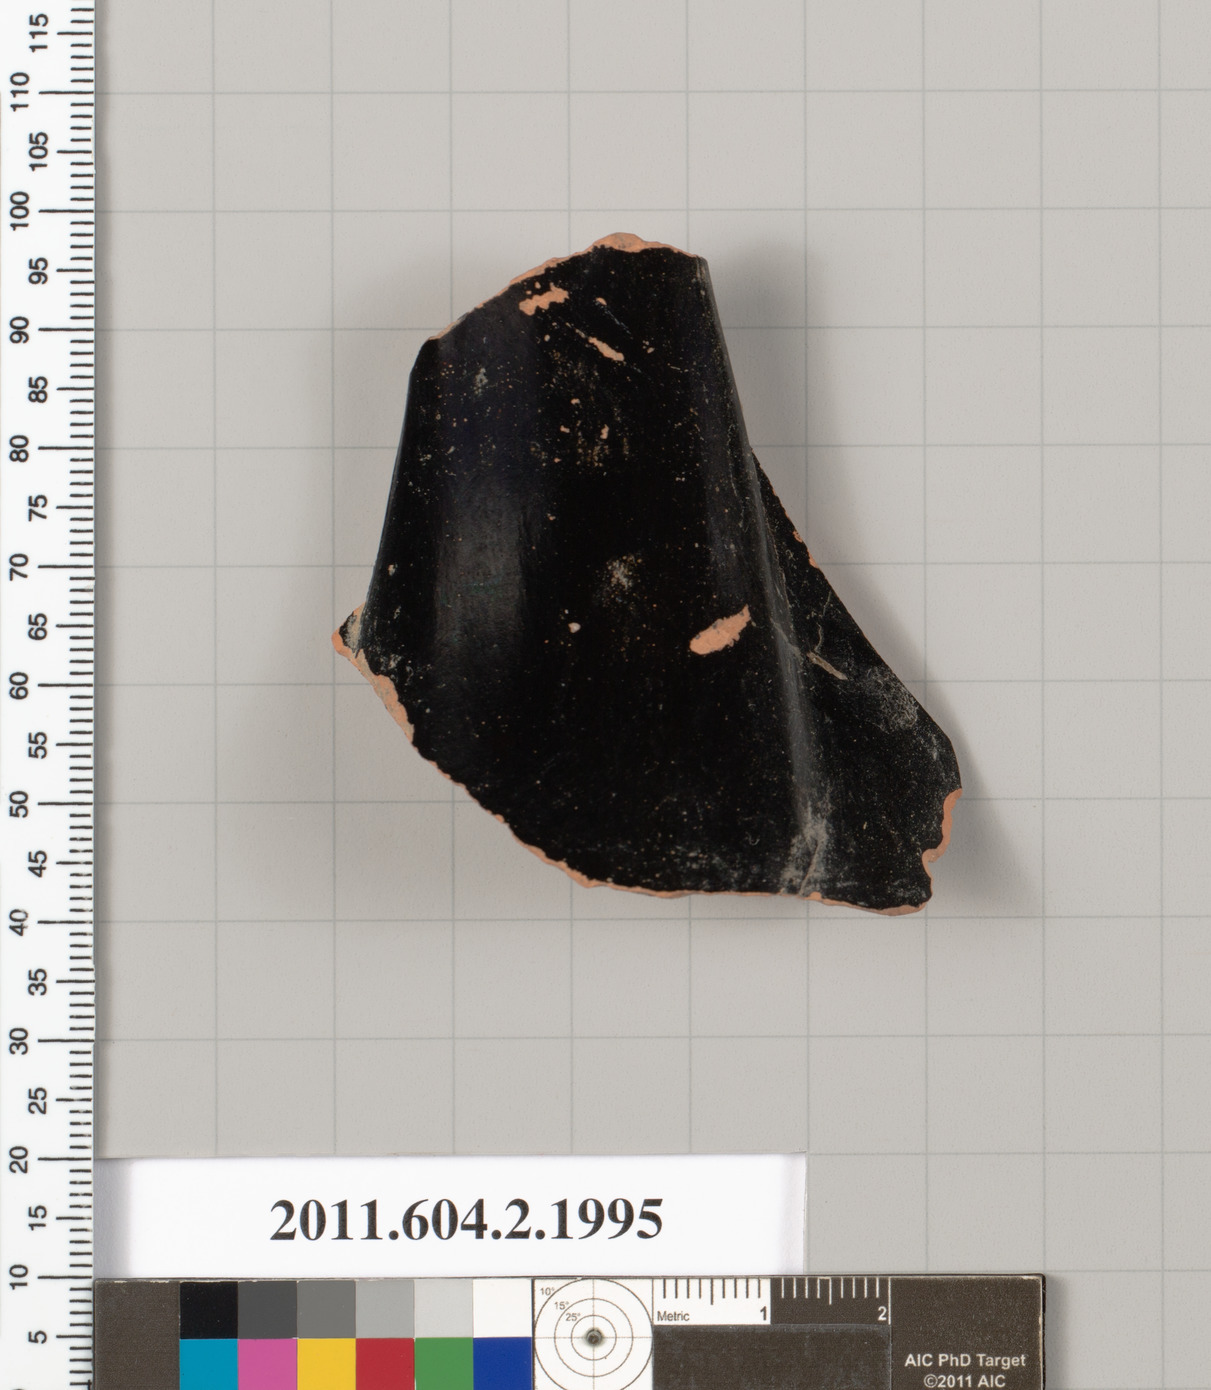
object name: pelike fragment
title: Terracotta fragment of a pelike (jar)?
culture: greek, attic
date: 475-451 BCE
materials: terracotta